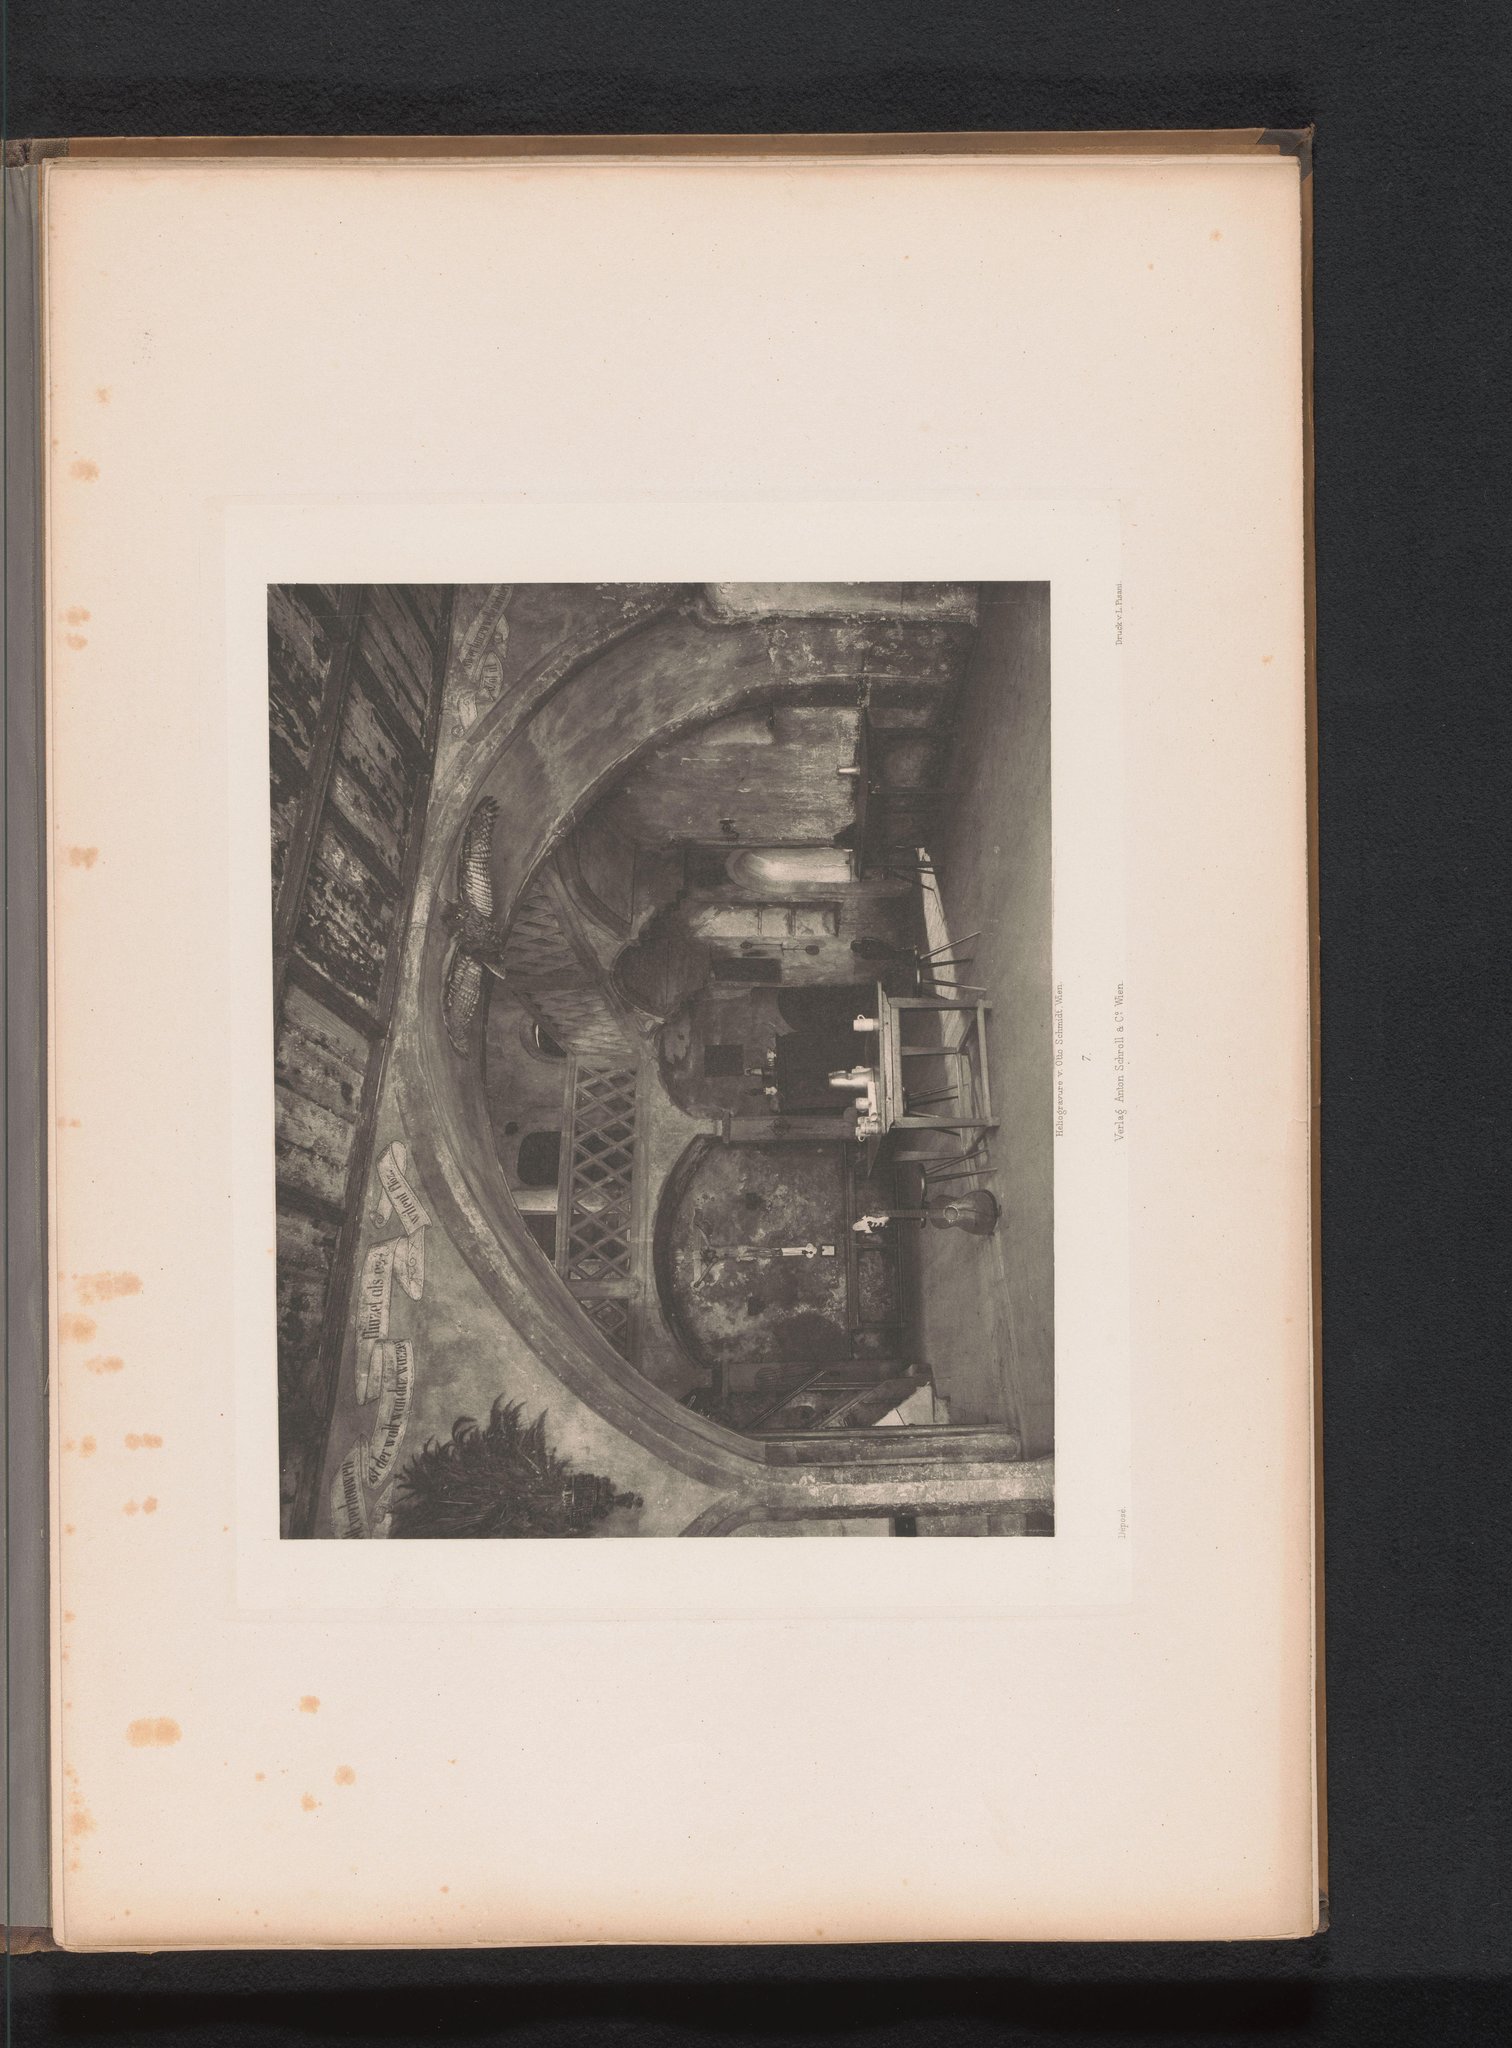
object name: photomechanical print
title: Gezicht op een kamer in een woning in Klausen, Italië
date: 1886-1891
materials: paper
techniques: photoaquatint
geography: klausen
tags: other rooms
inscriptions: inscription: ‘Déposé.’, number: ‘7.’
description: Deze prent maakt deel uit van een omslag met dertig prenten en drie tekstbladen.